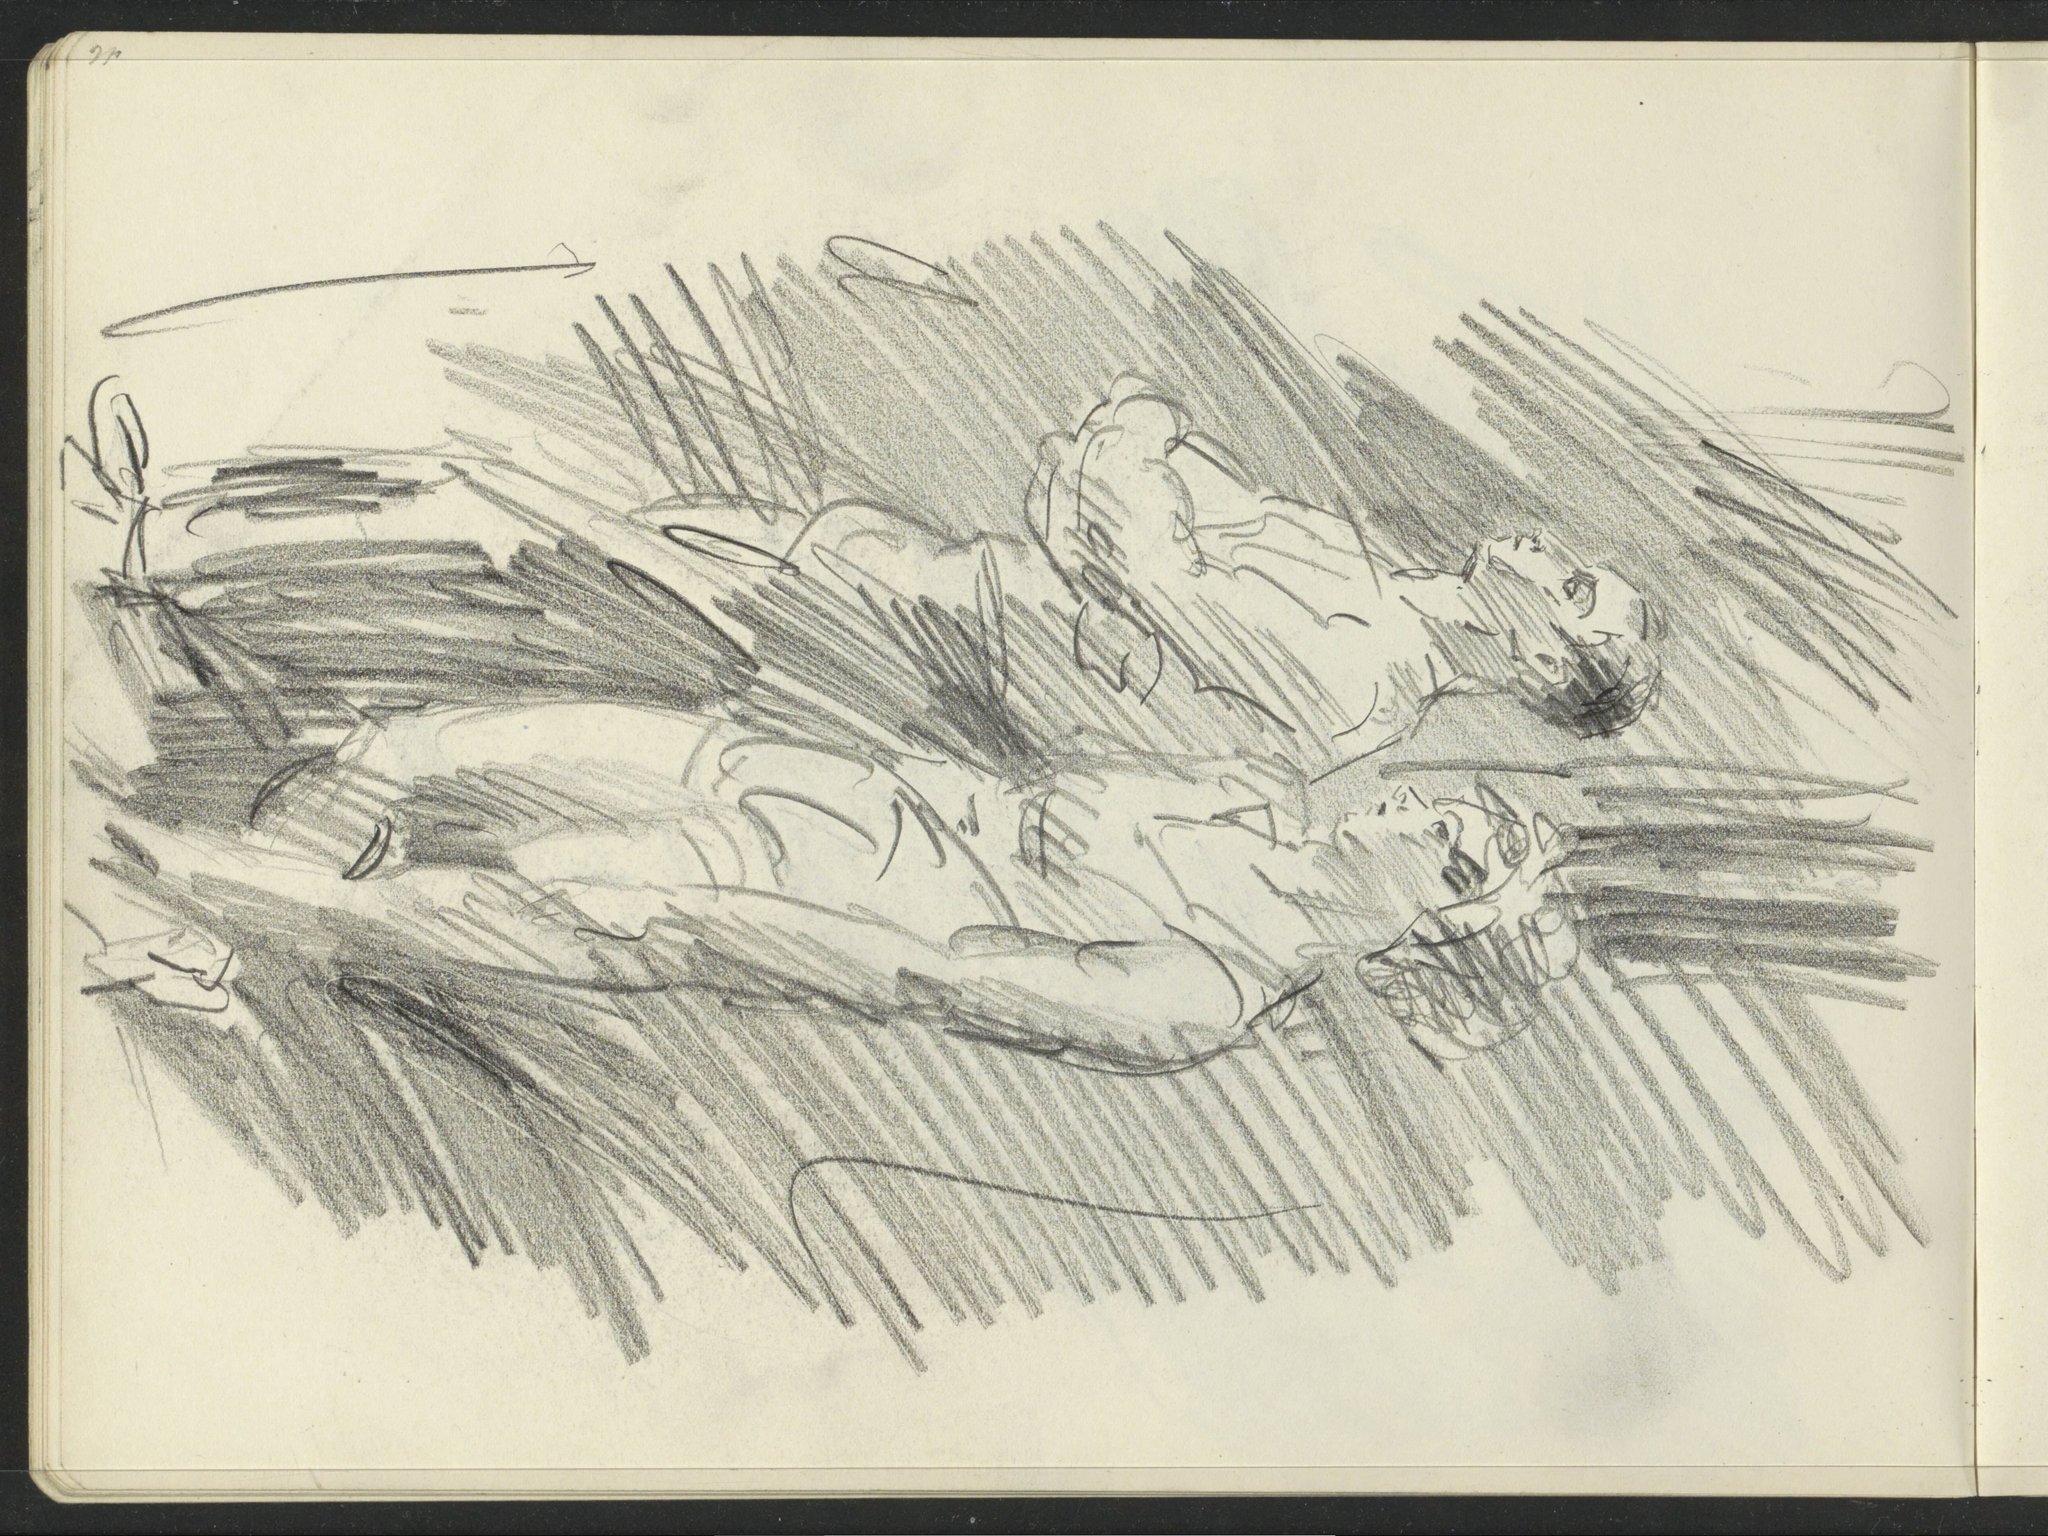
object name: sketchbook leaf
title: Twee staande figuren, mogelijk acrobaten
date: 1915-1934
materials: paper, pencil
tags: acrobat ~ circus, adult woman (+ standing), adult man (+ standing)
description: Mogelijk een man en een vrouw. Blad 19 verso uit schetsboek XVI met 32 bladen.